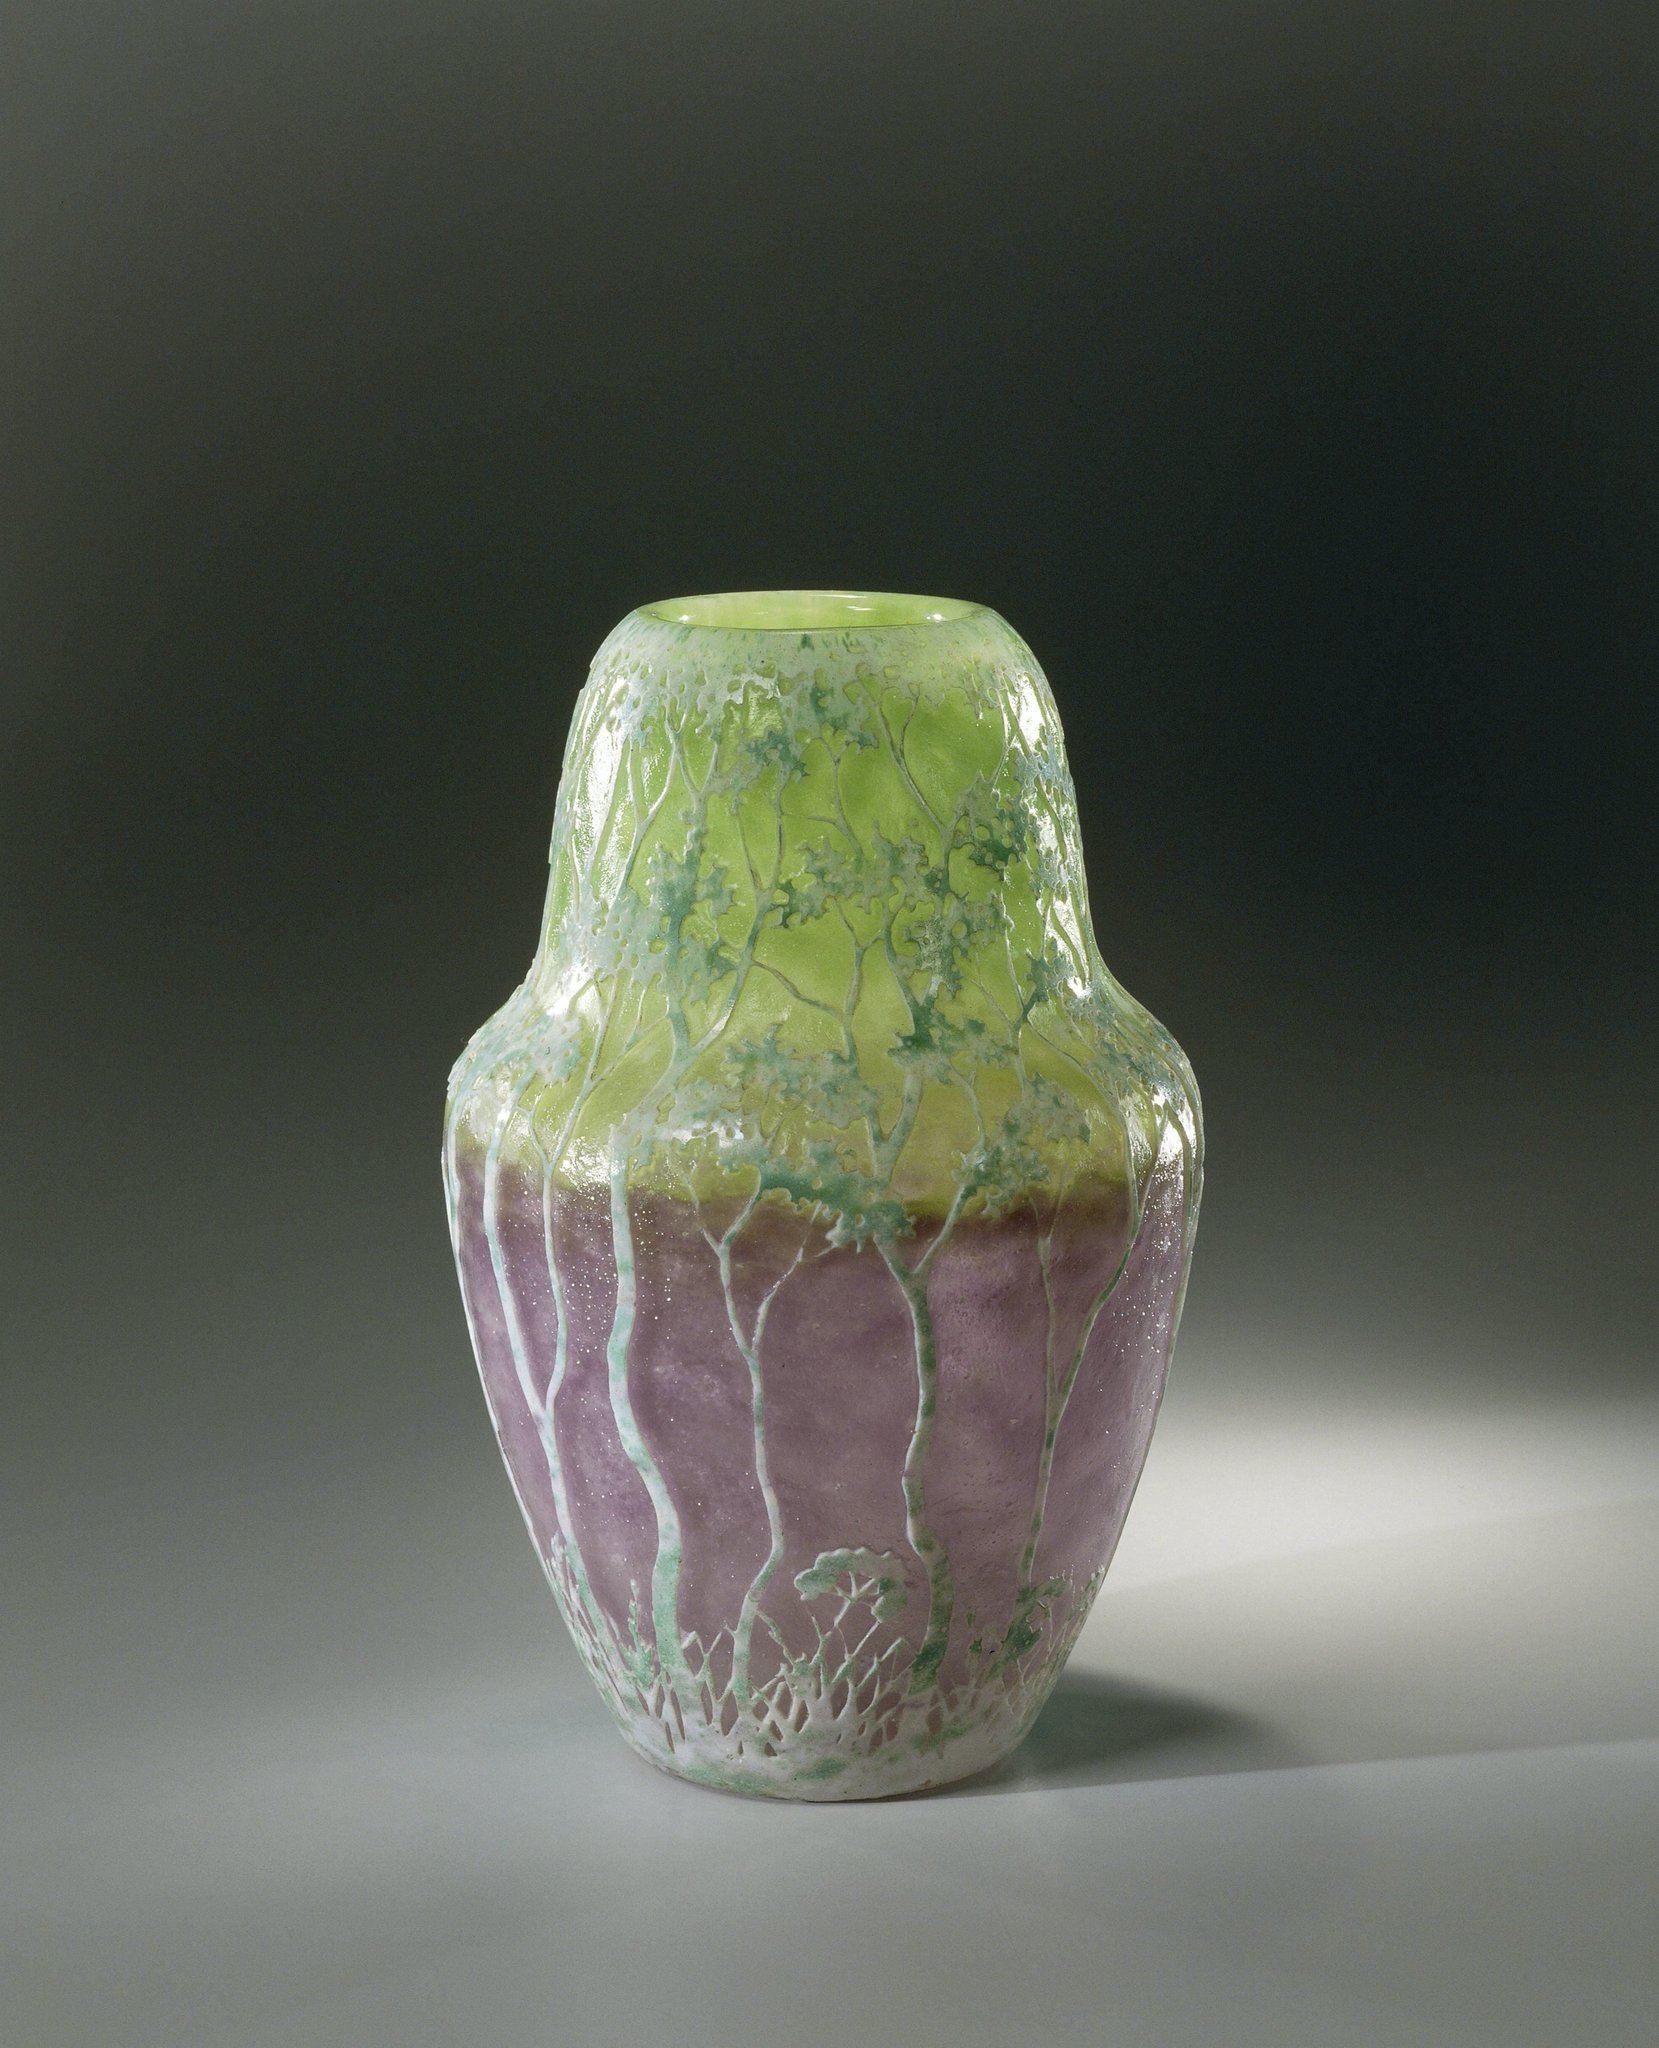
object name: vase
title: Vaas met planten en bomen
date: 1900-1910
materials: glass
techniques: etching, glassblowing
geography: nancy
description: Vase. Glass. Nancy, c. 1900 - 1910, by Daum Frères.